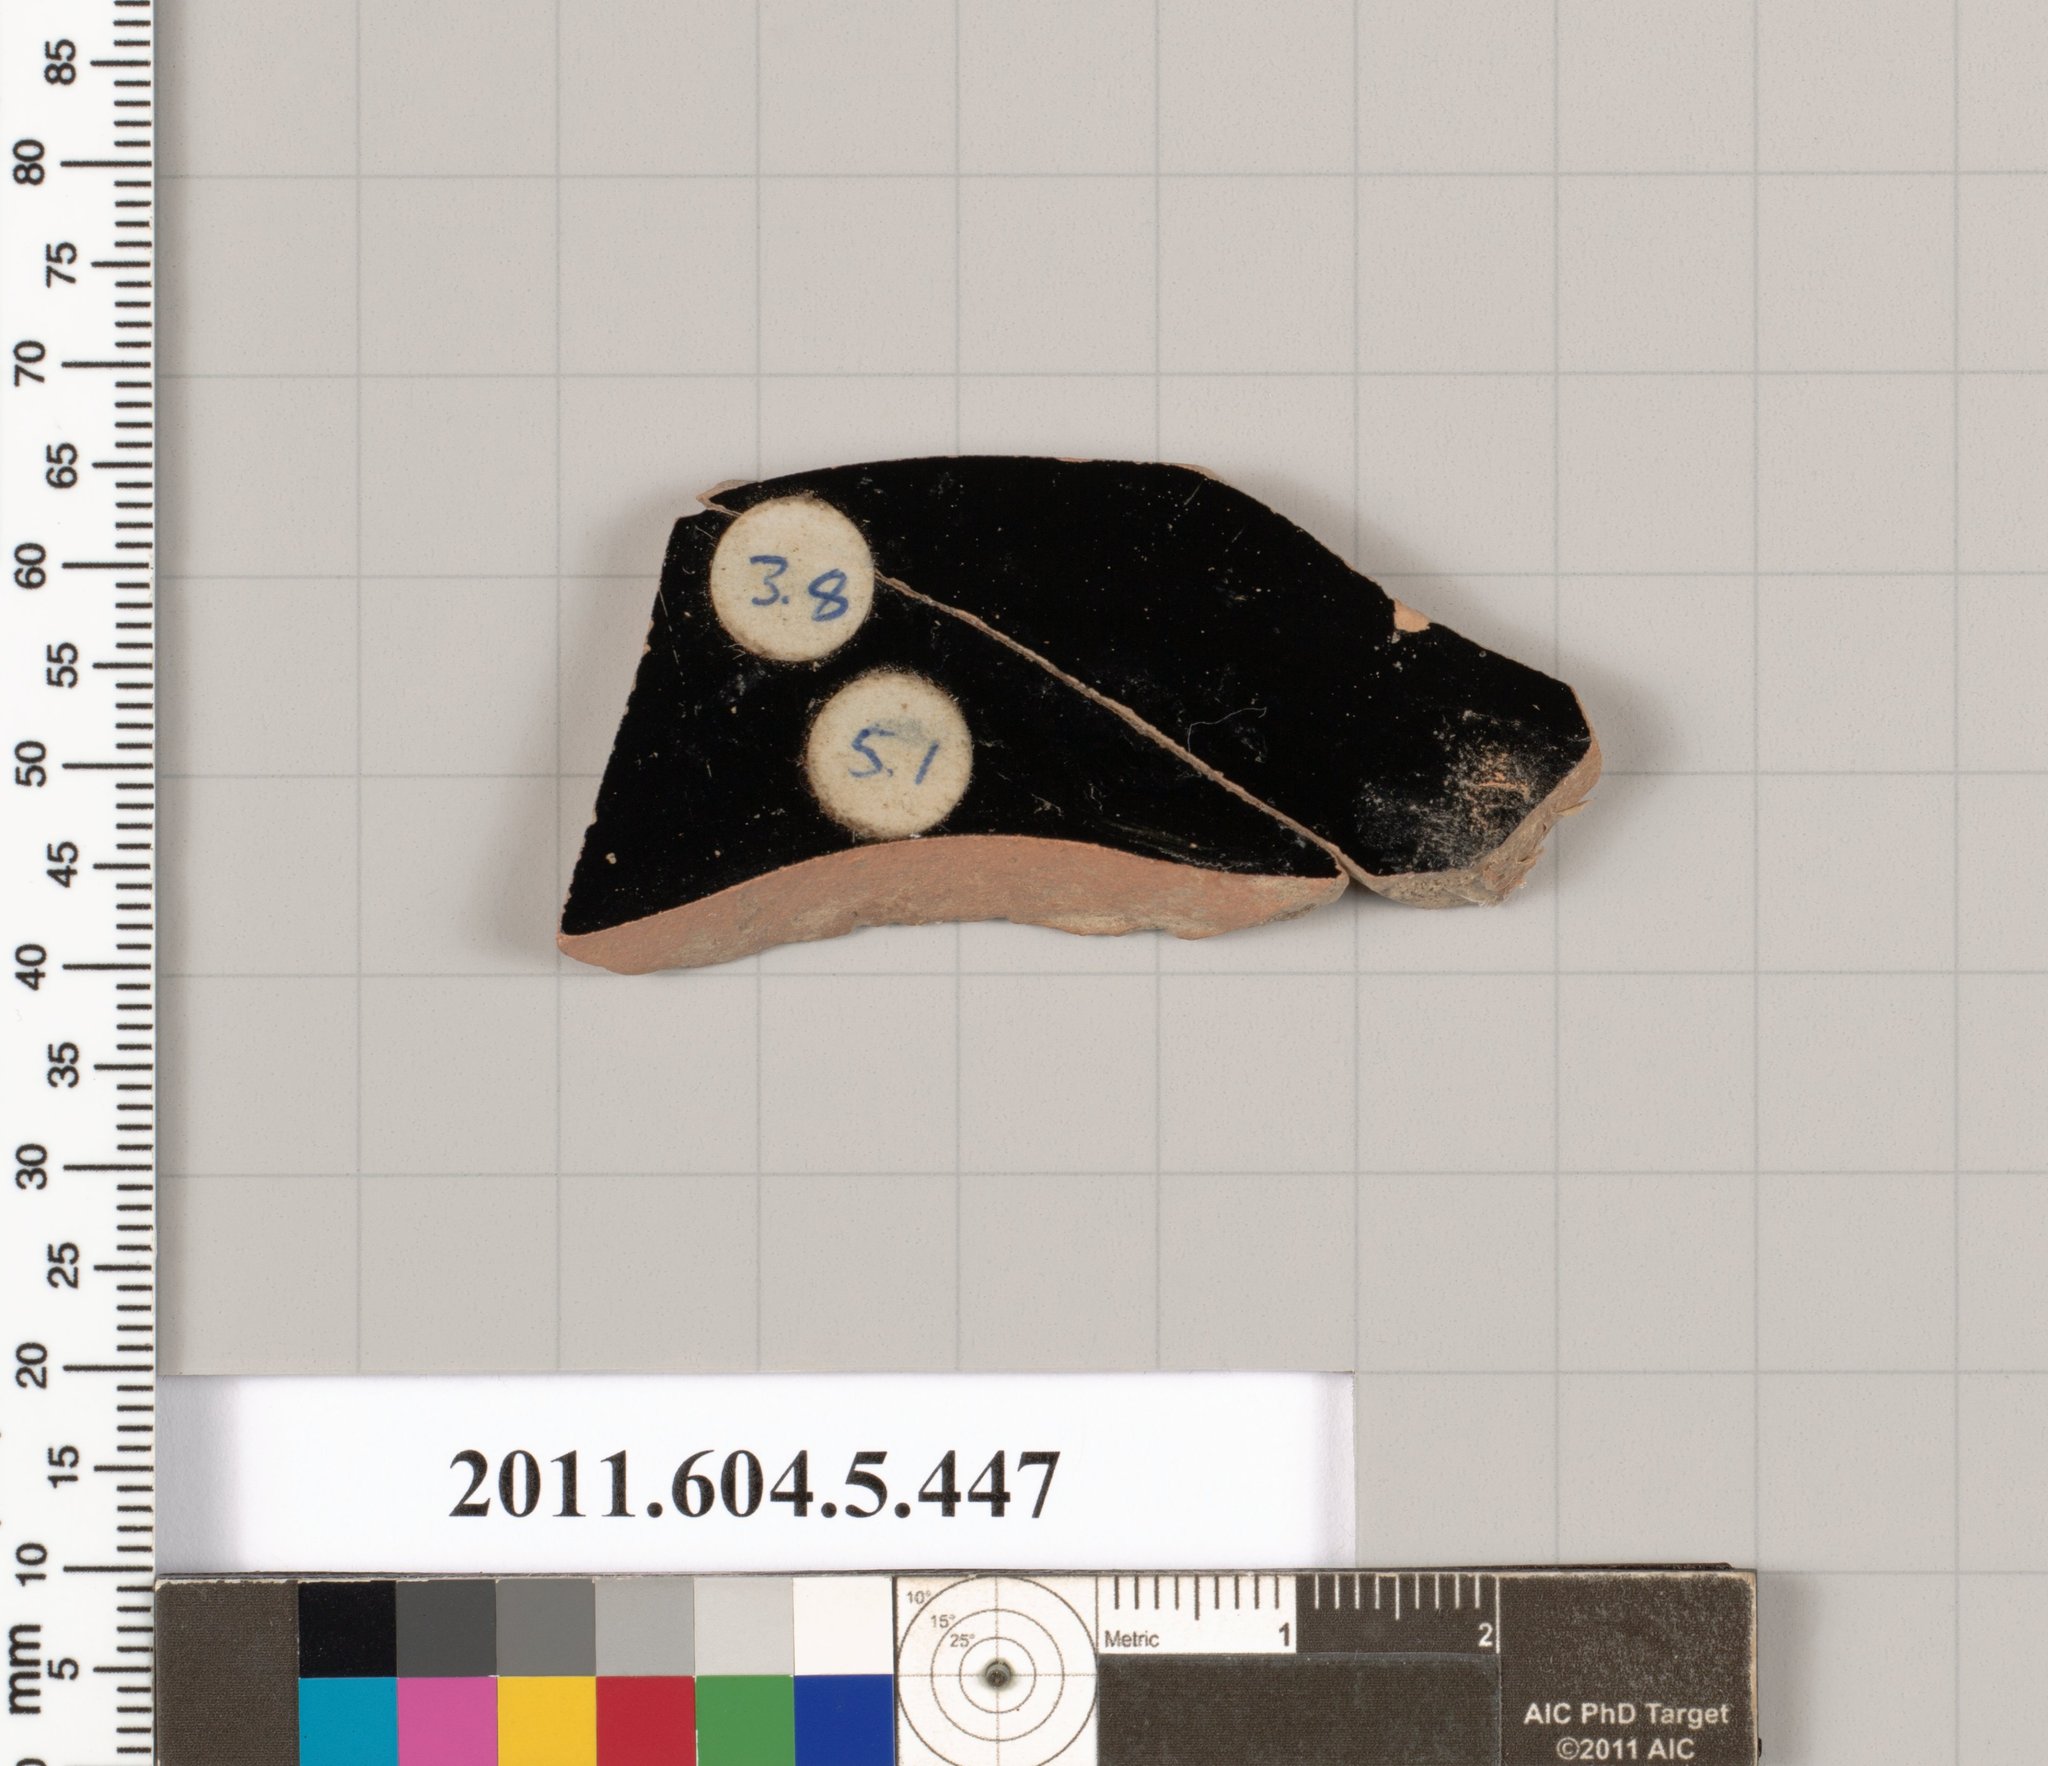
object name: kylix fragment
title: Terracotta fragment of a kylix (drinking cup)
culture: greek, attic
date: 600-401 BCE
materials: terracotta